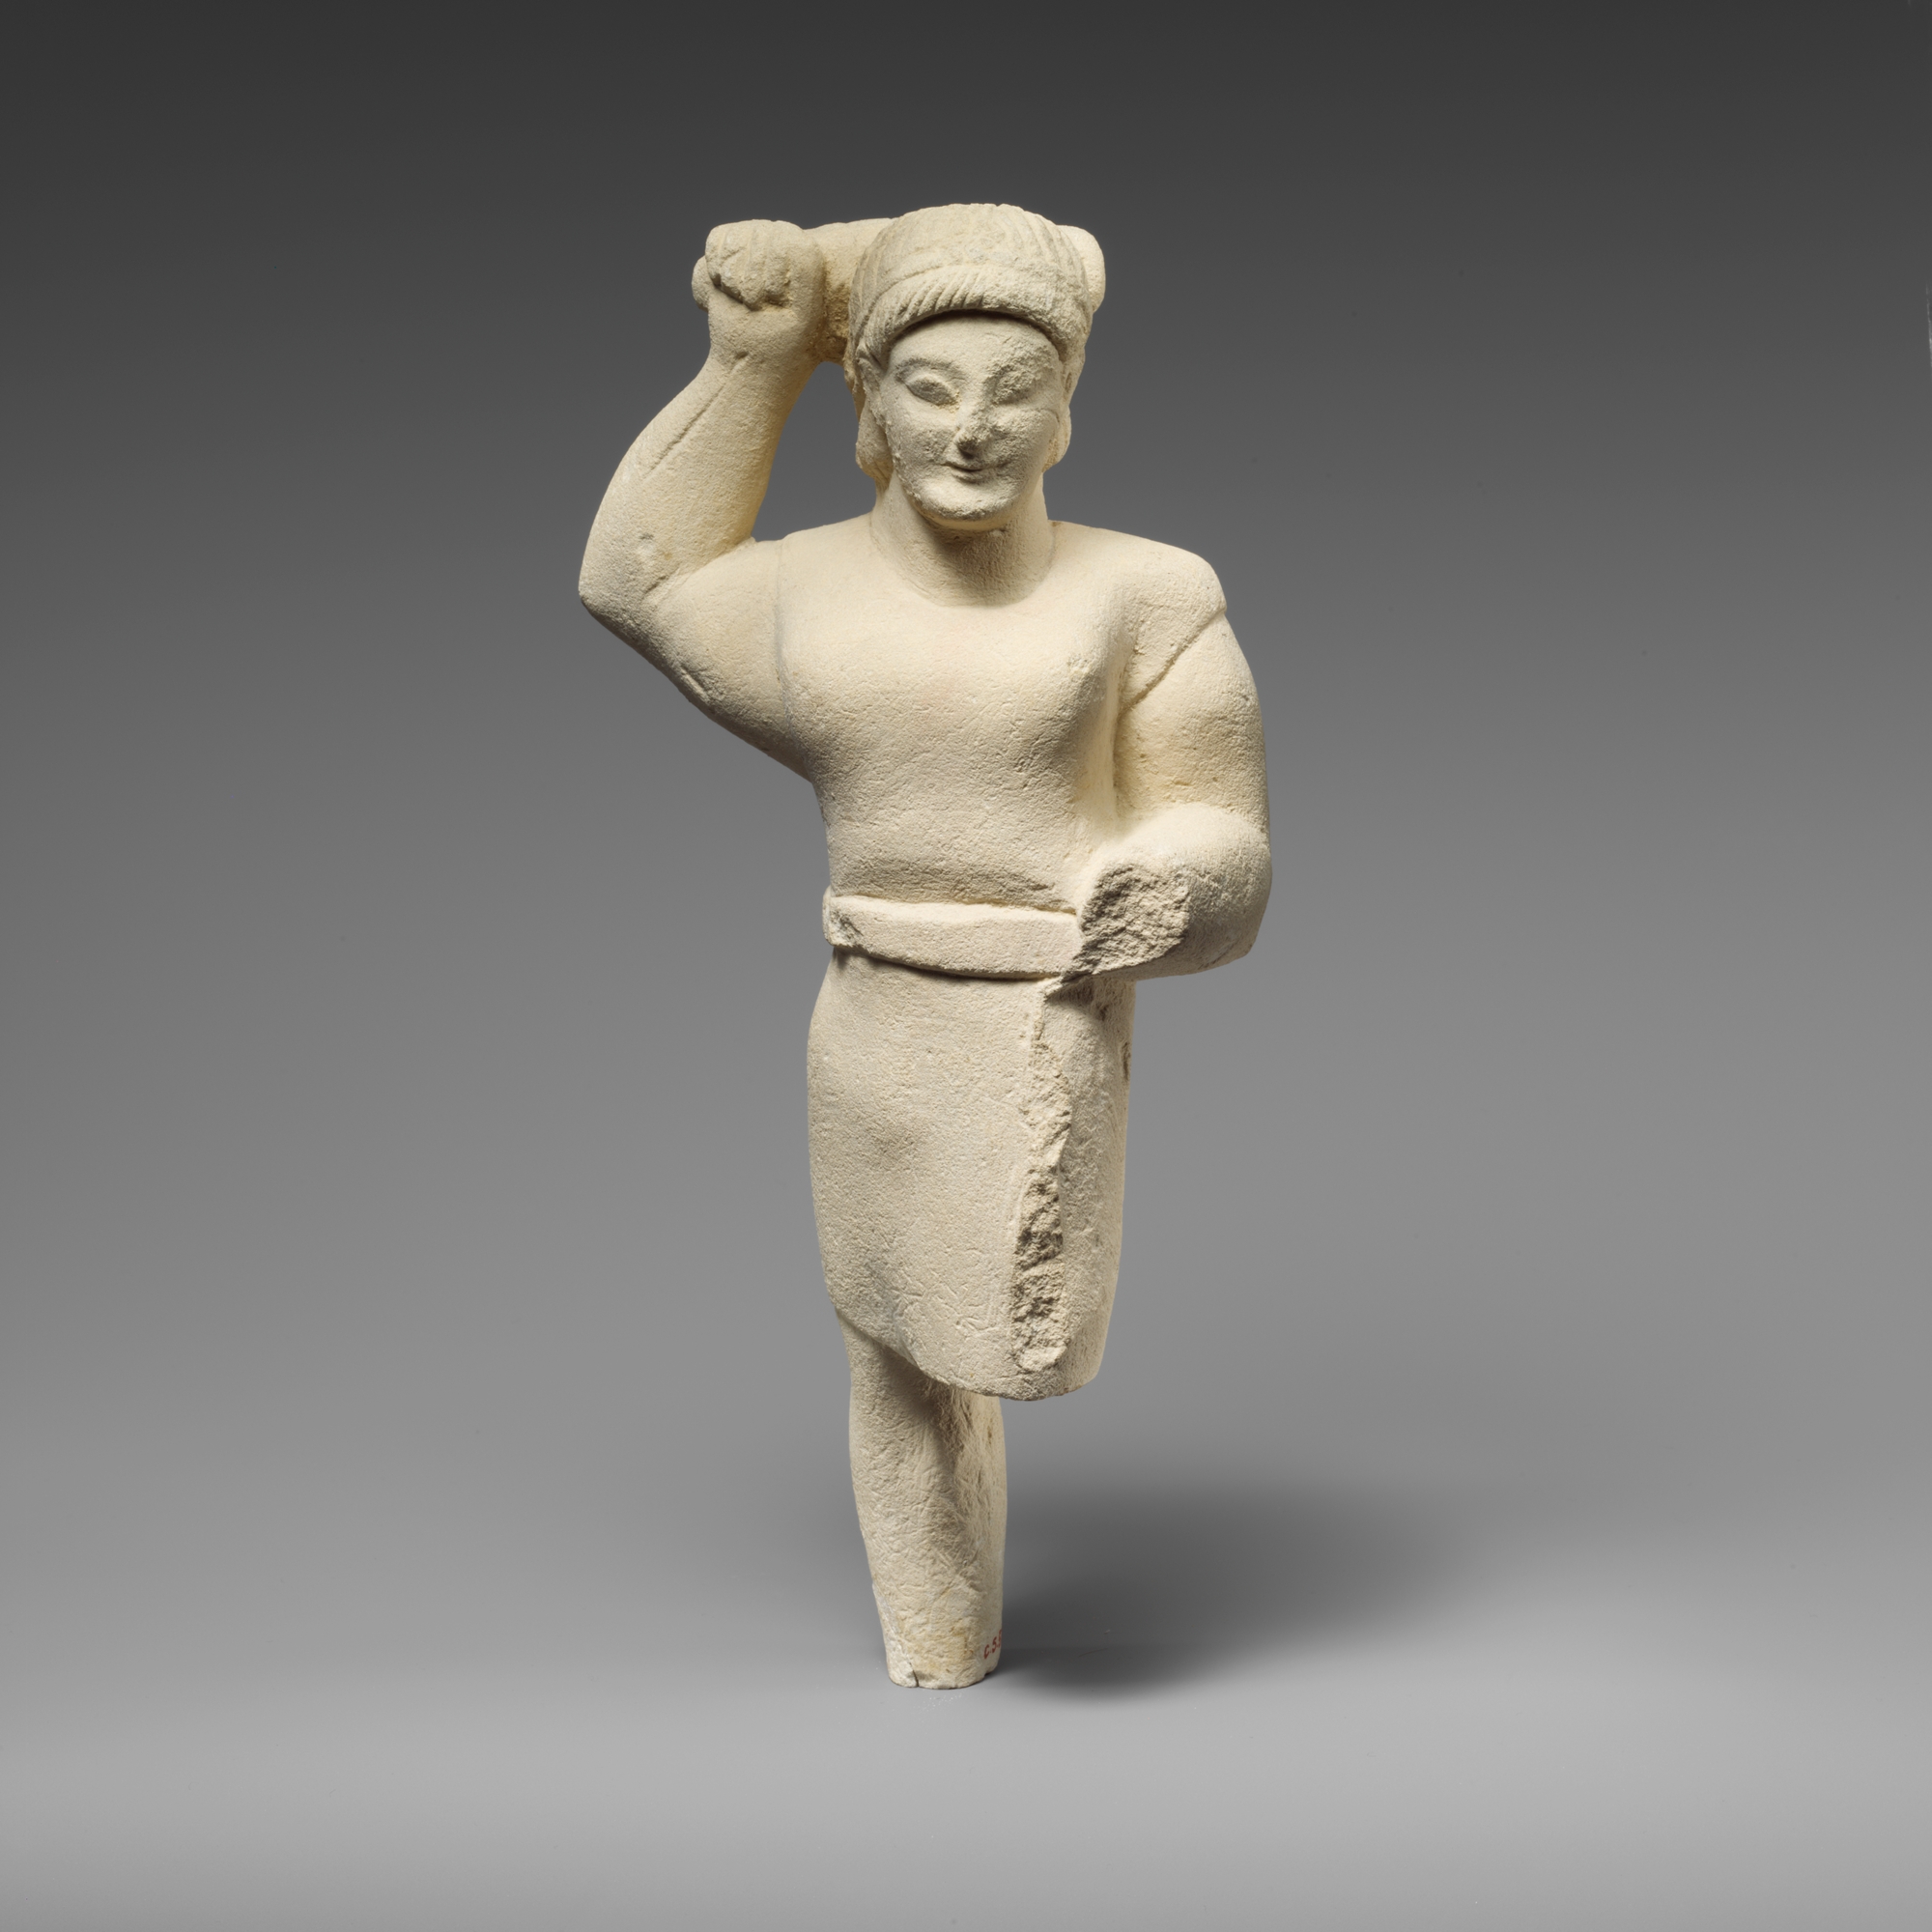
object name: statuette of herakles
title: Limestone statuette of Herakles brandishing a club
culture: cypriot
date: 500-451 BCE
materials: limestone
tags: men,herakles